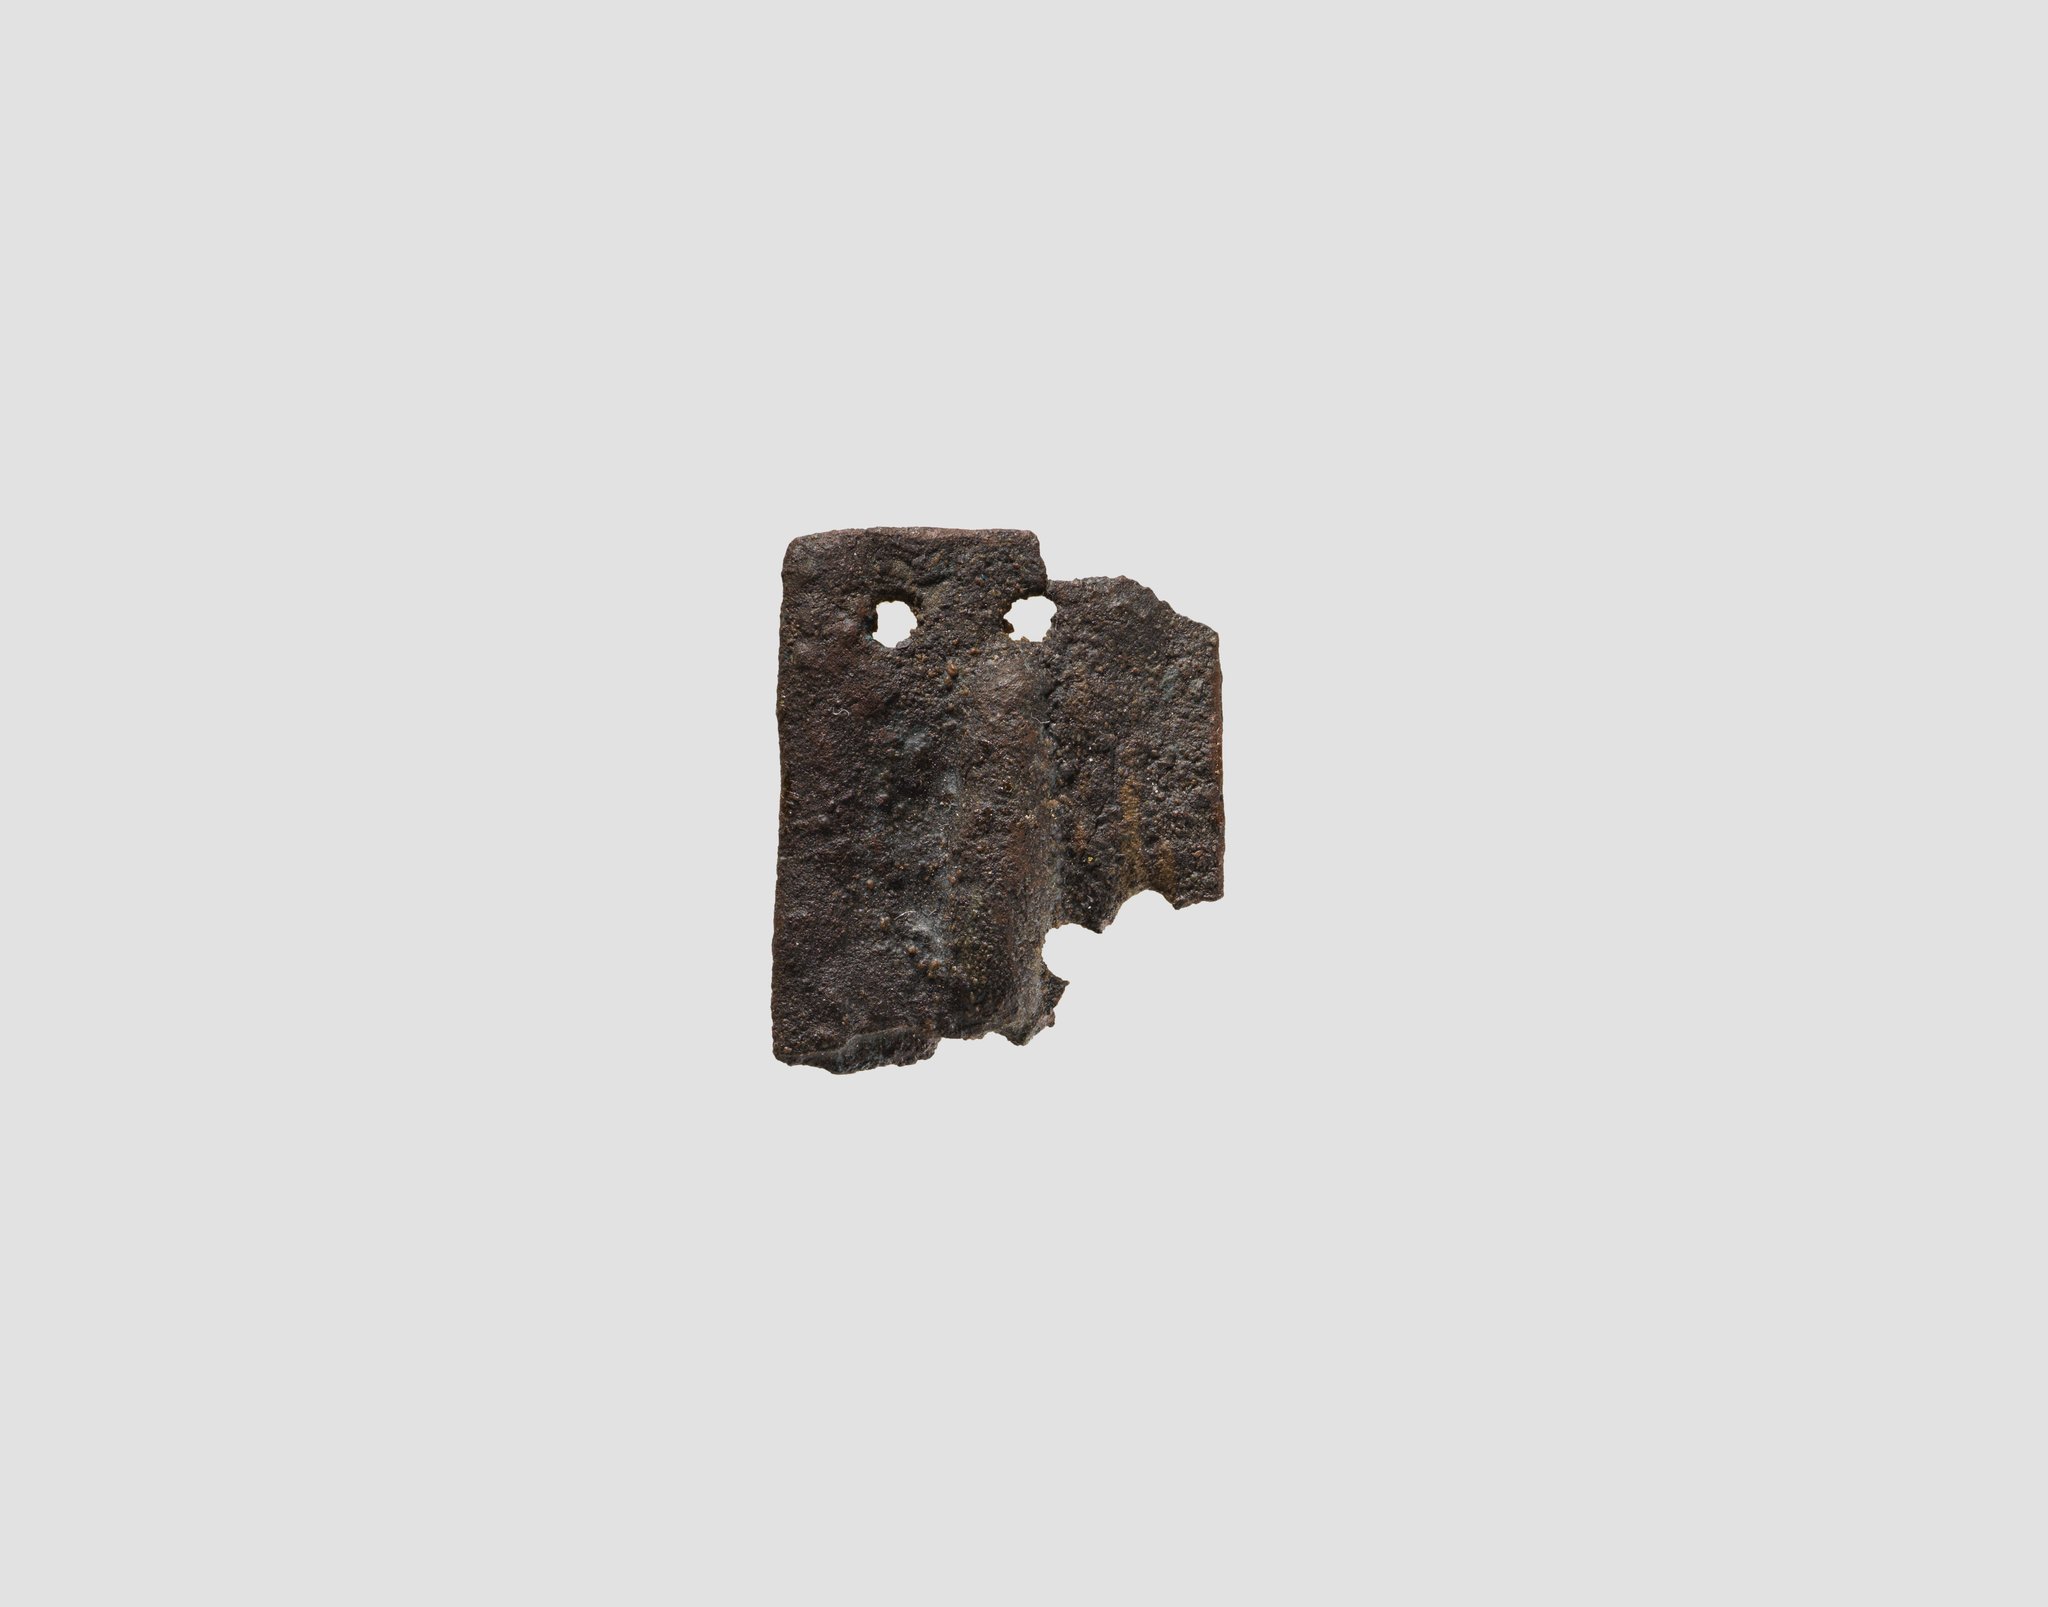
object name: armor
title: Armor plate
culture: assyrian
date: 734-601 BCE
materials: bronze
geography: mesopotamia